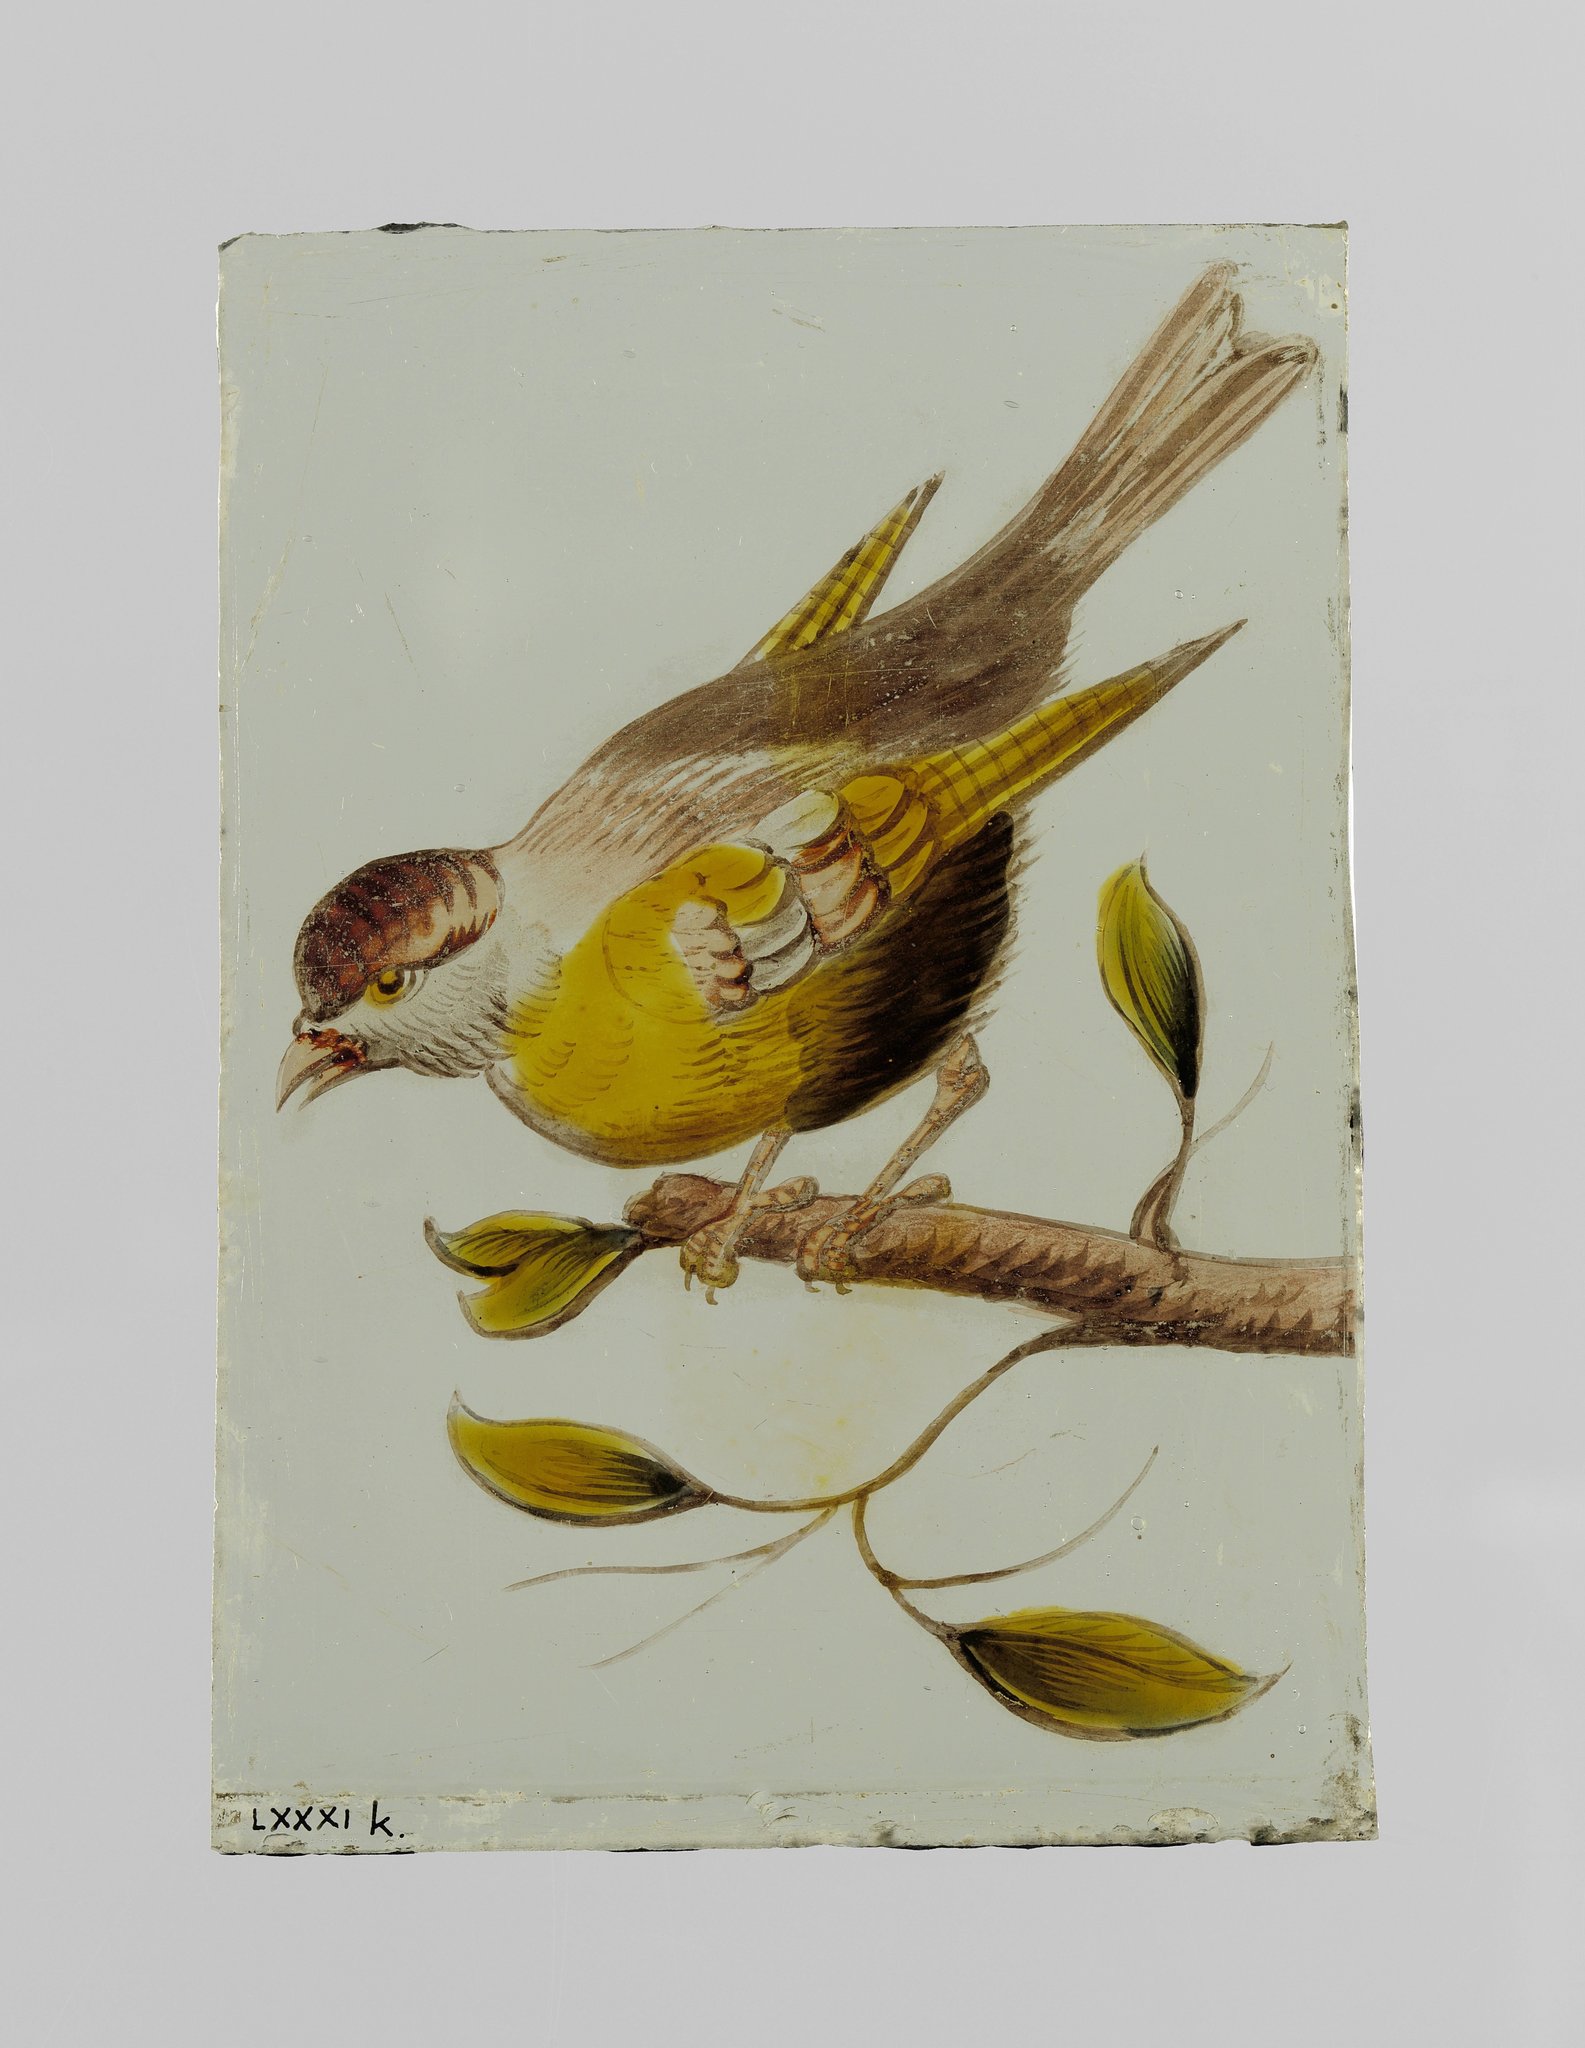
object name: light window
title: Ruit met een vogel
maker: Anonymous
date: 1650-1675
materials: glass, lead, pigment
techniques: enamel painting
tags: birds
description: Een ruit met emailschildering van een vogel in rood, zilvergeel en grisaille.